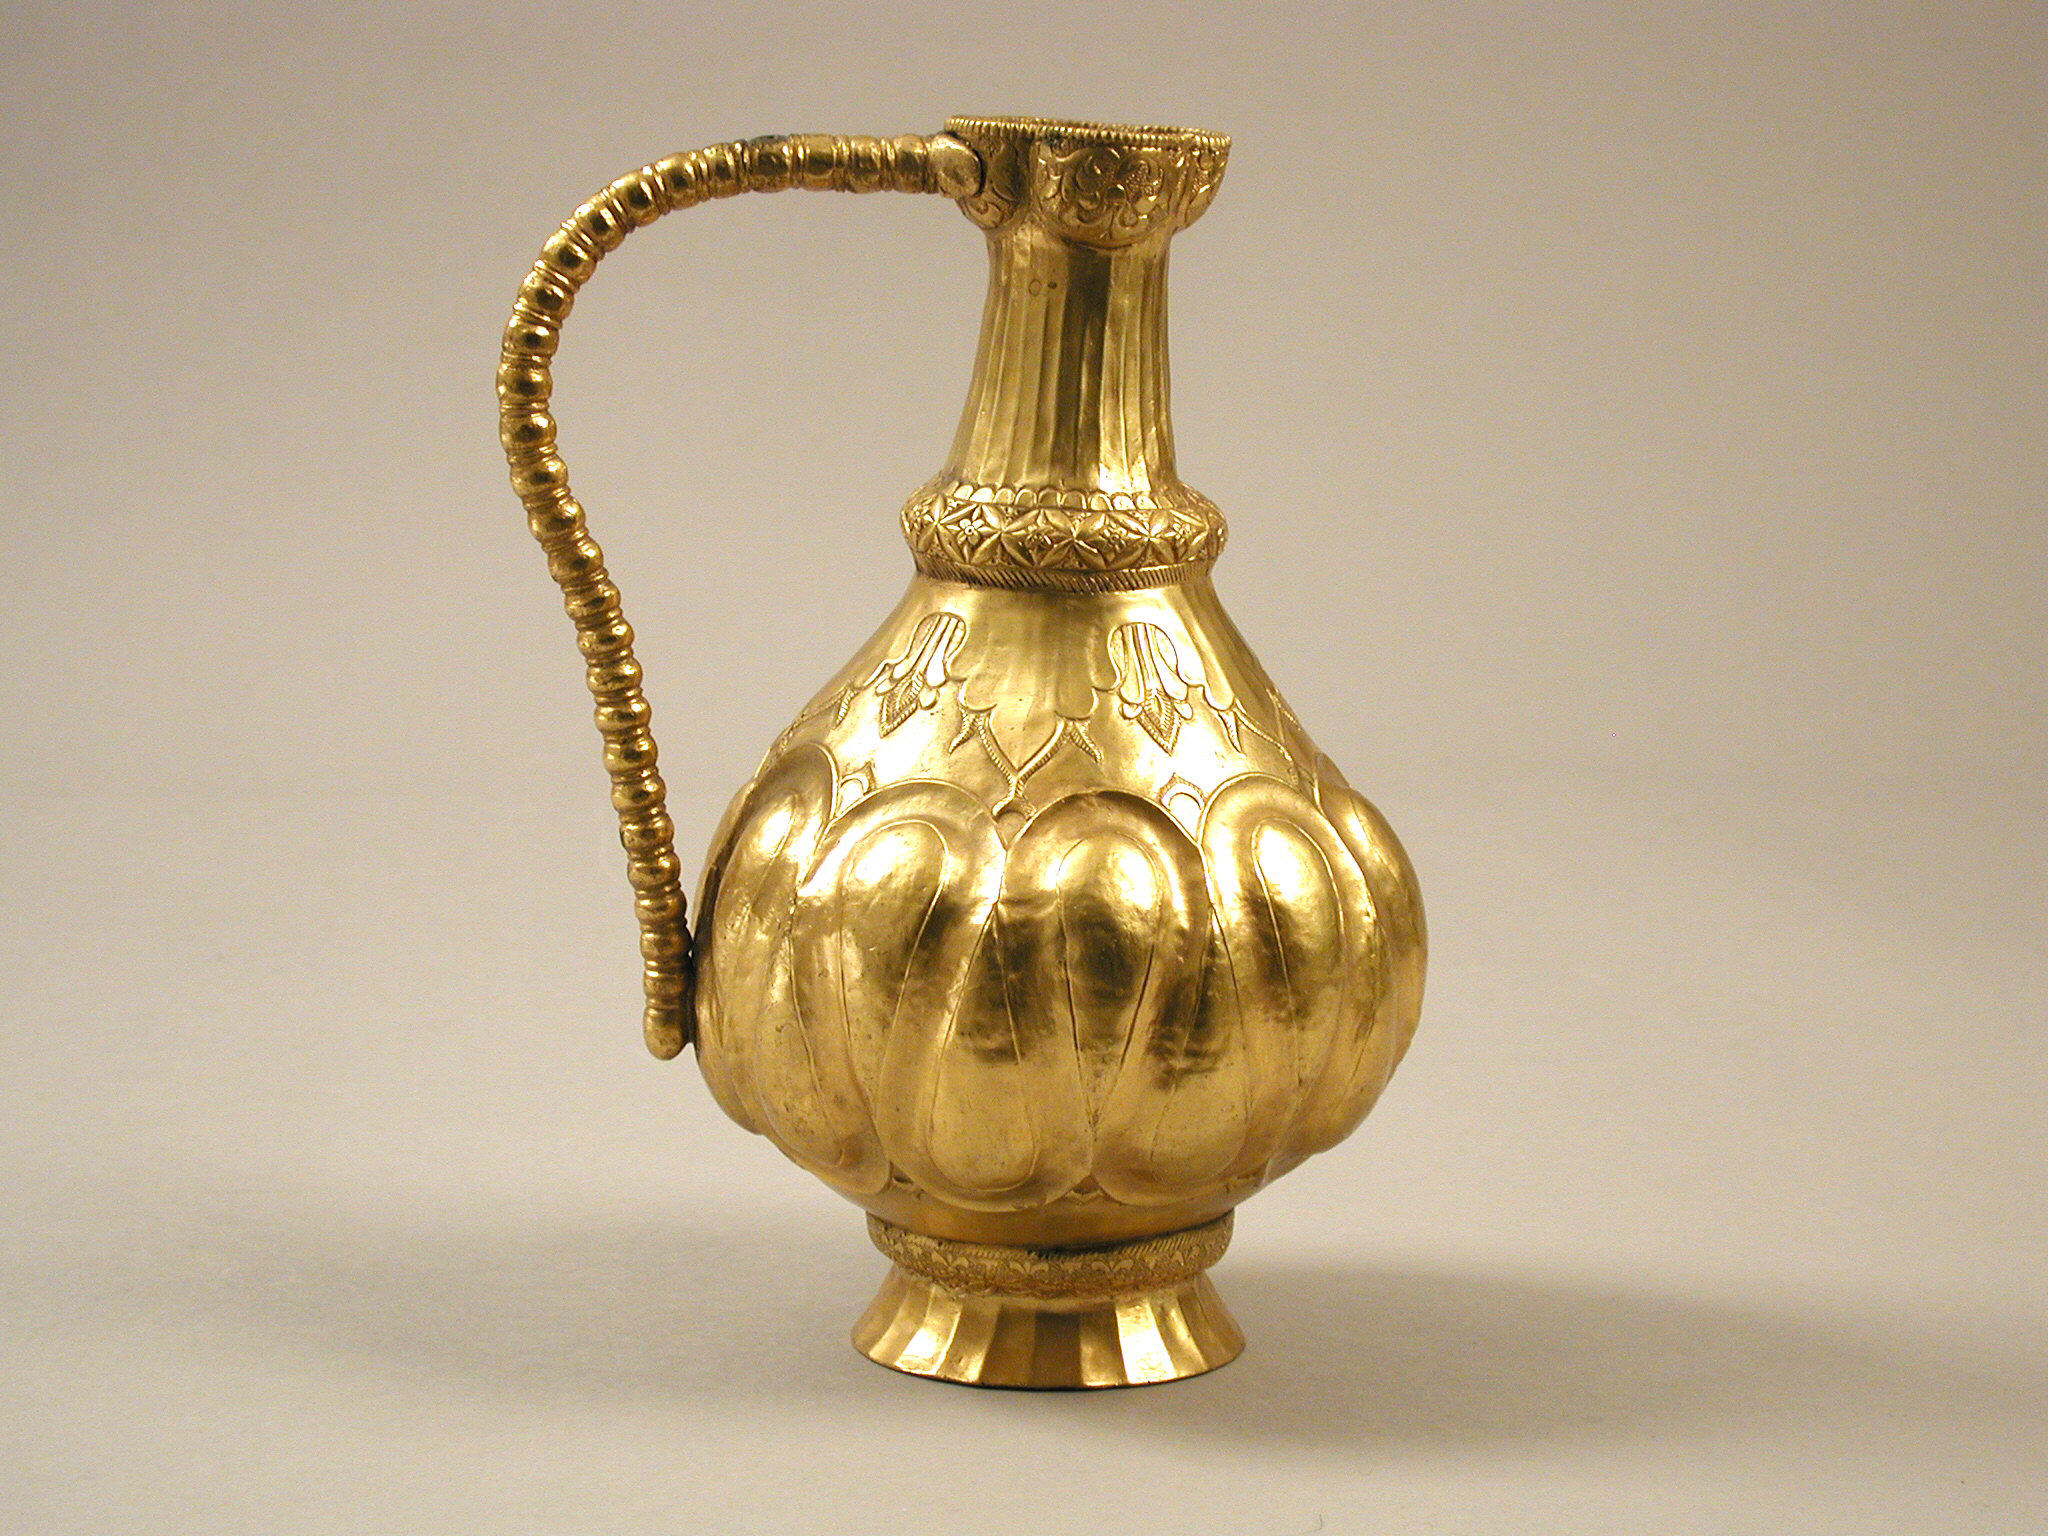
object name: ewer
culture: scythian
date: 1801-1900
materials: gold